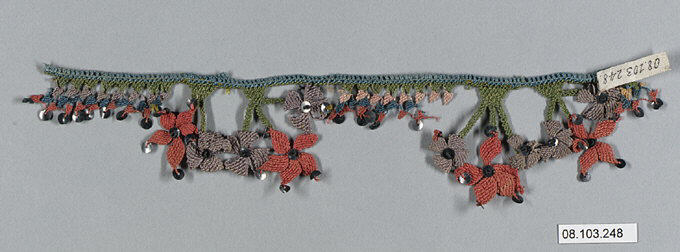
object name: trimming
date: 1701-1900